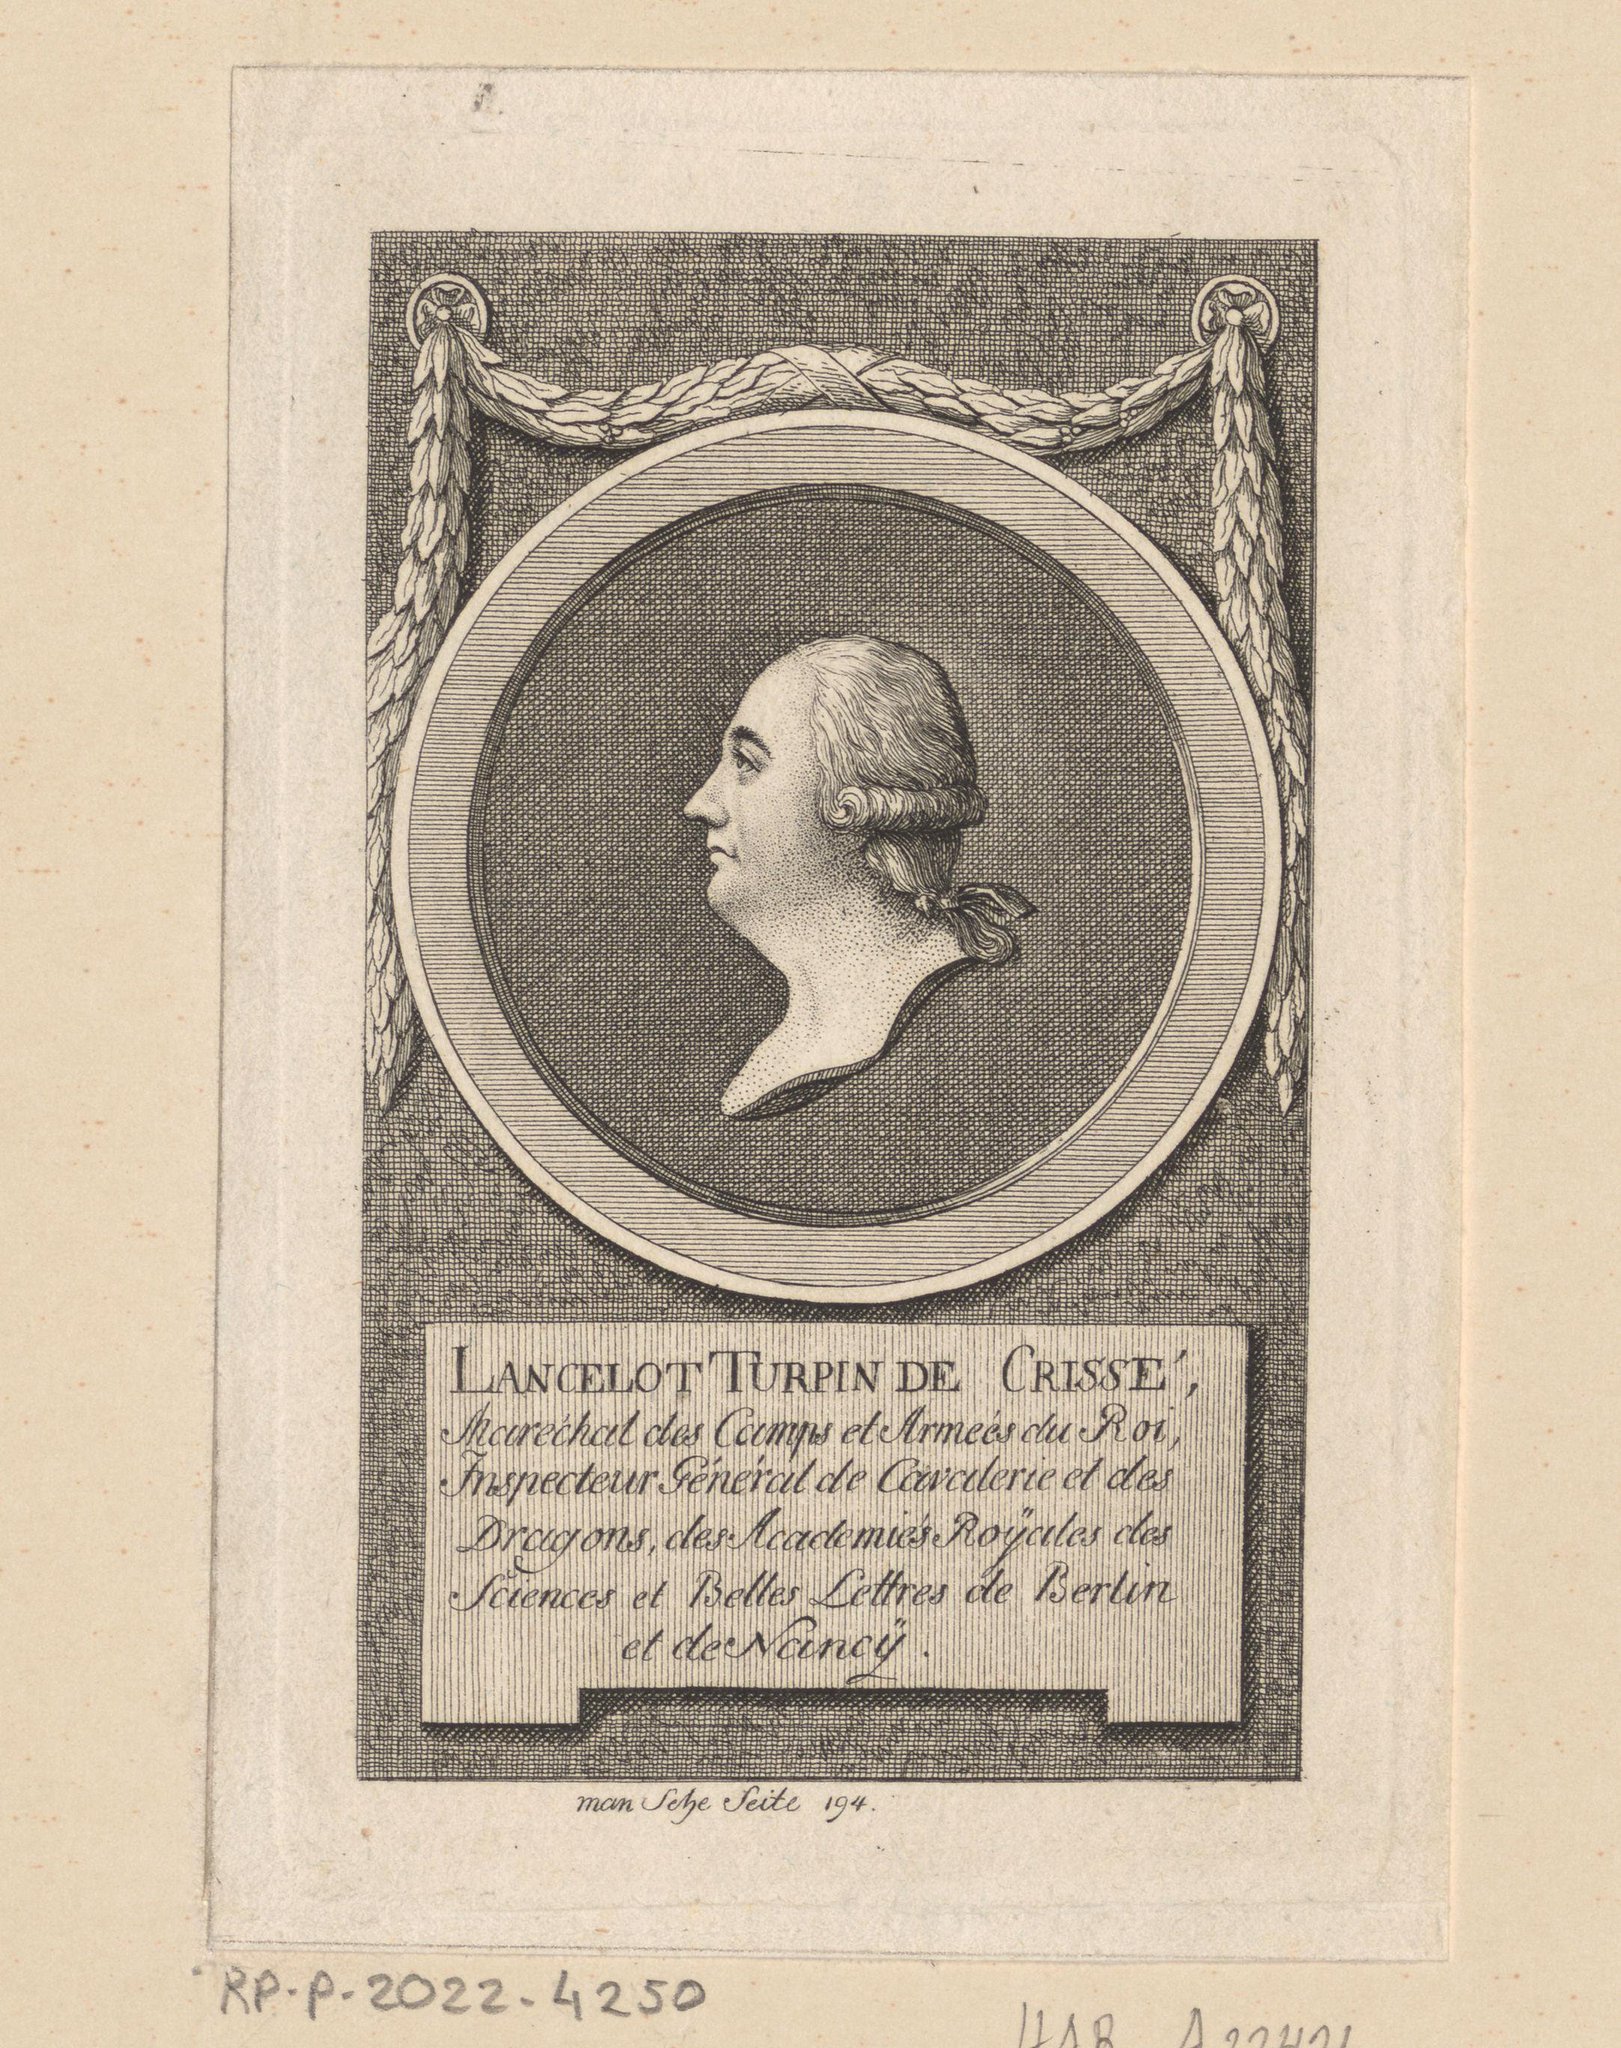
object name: print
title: Portret van Lancelot comte Turpin de Crissé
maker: Anonymous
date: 1760-1800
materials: paper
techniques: etching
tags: germany, commander-in-chief, general, marshal, historical persons, portrait of a writer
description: Met onderschrift in het Frans. In de marge genummerd: man sehe Seite 194.